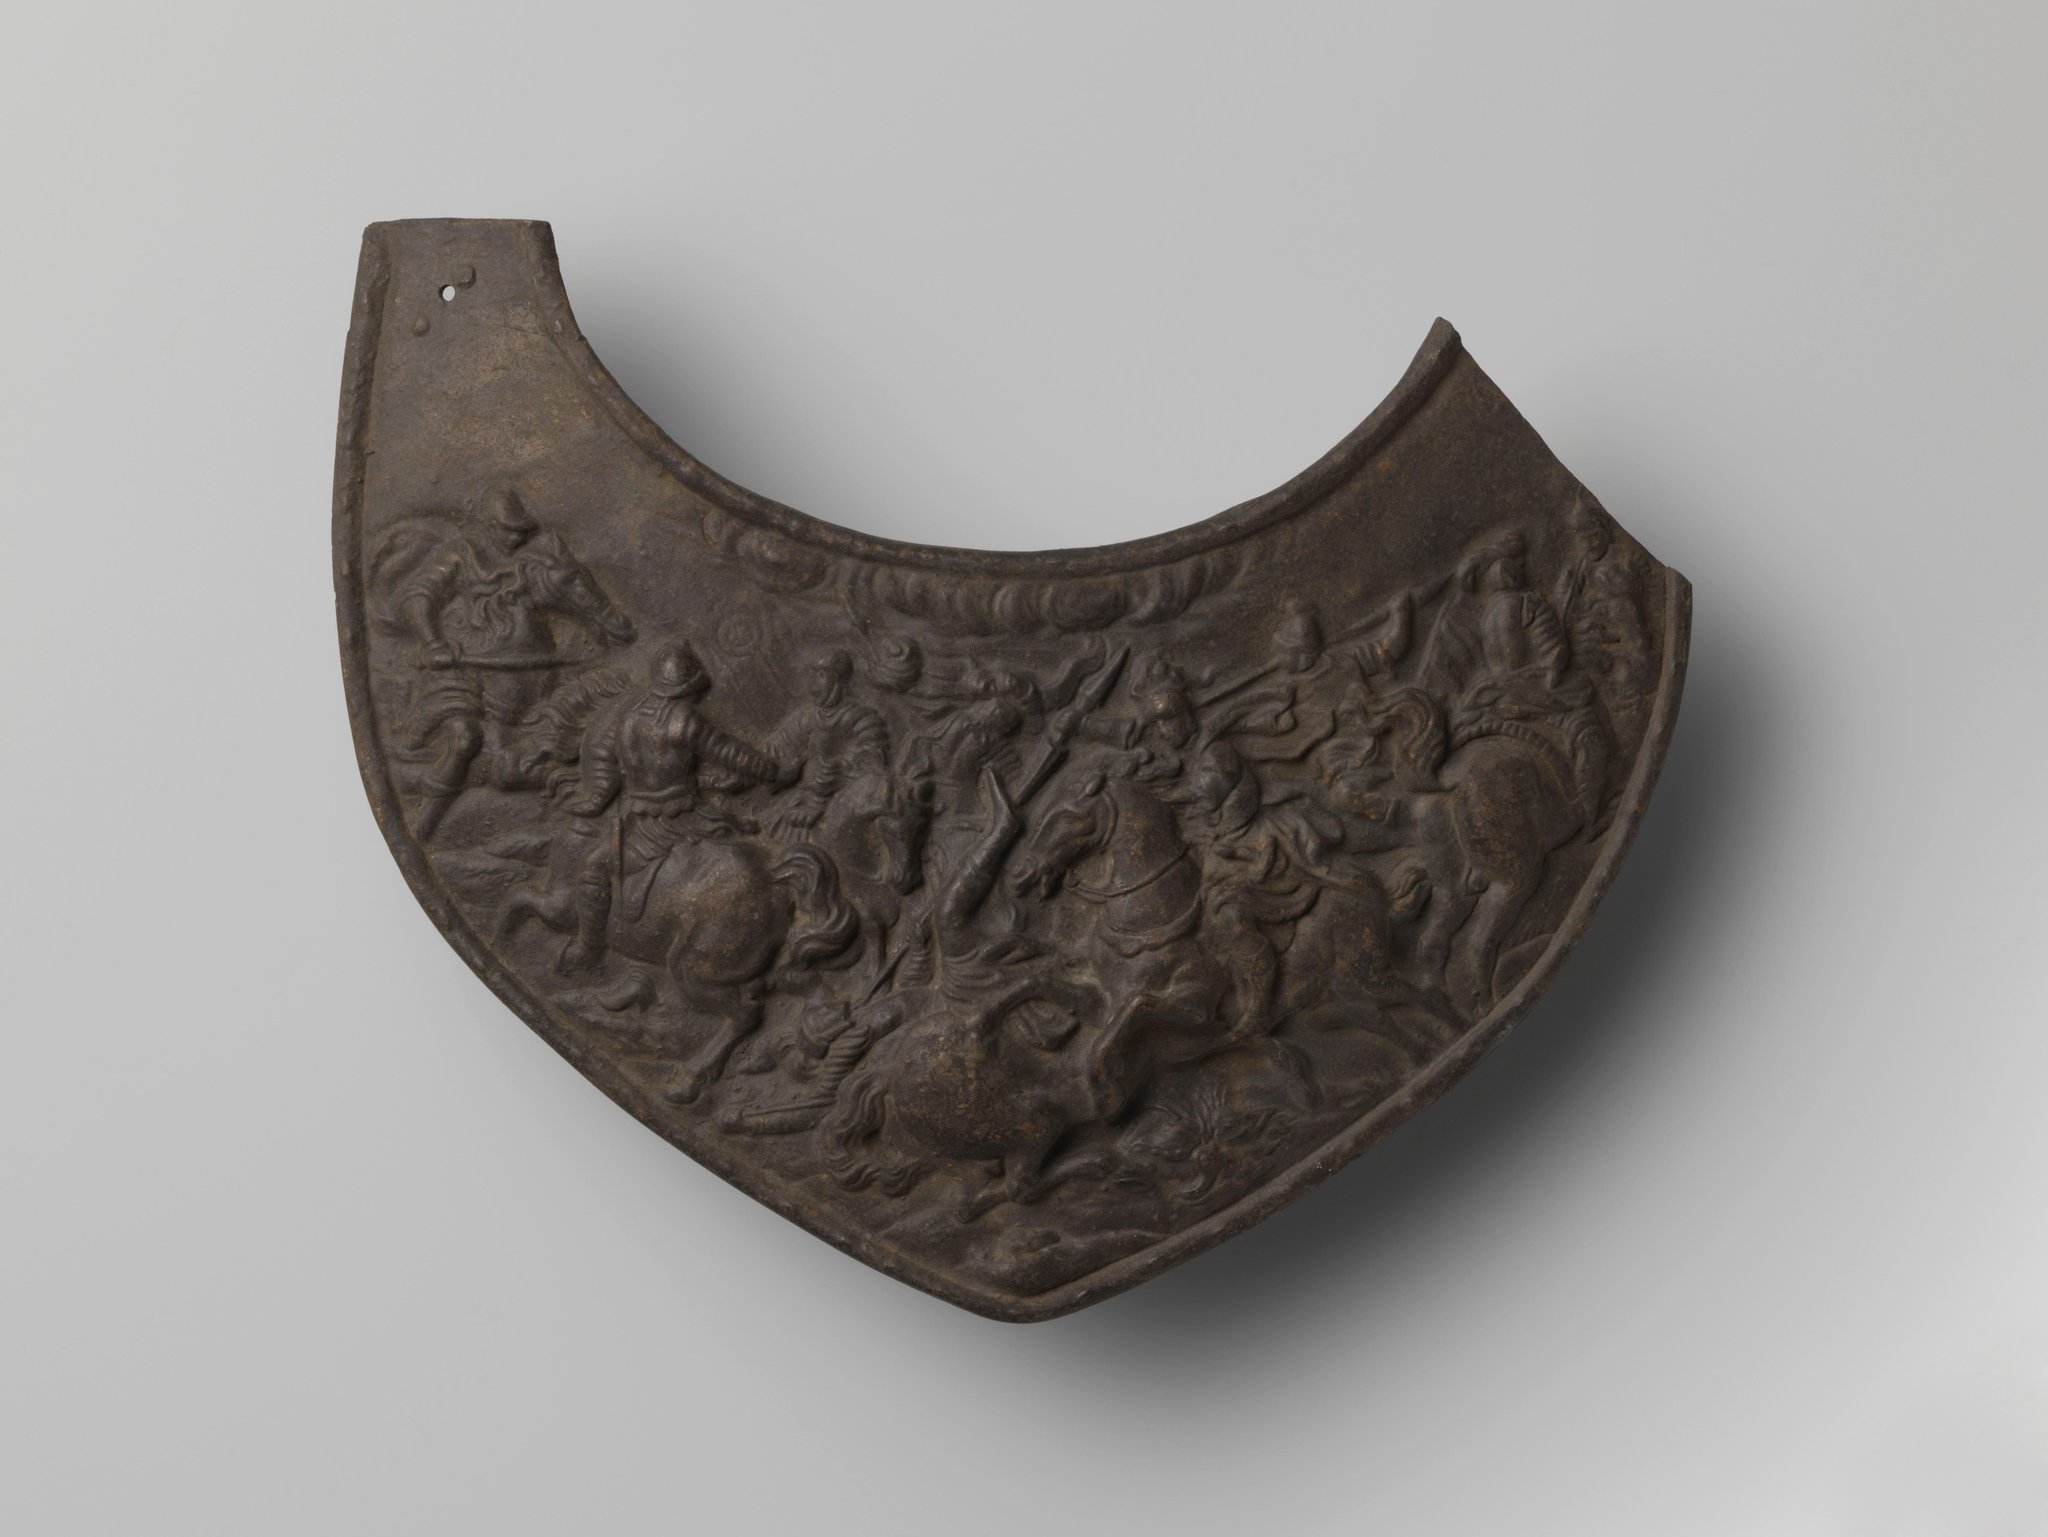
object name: gorget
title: Ringkraag van een harnas met relief van veldslag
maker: Anonymous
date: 1550-1650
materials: iron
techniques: metalworking, forging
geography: western europe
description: Ringkraag van ijzer. De bovenzijde is halfrond en de onderzijde loopt toe in een flauwe punt. Het hoogreliëf toont een veldslag met mannen te paard en met speren en zwaarden. In het midden valt een paard met berijder op de grond.